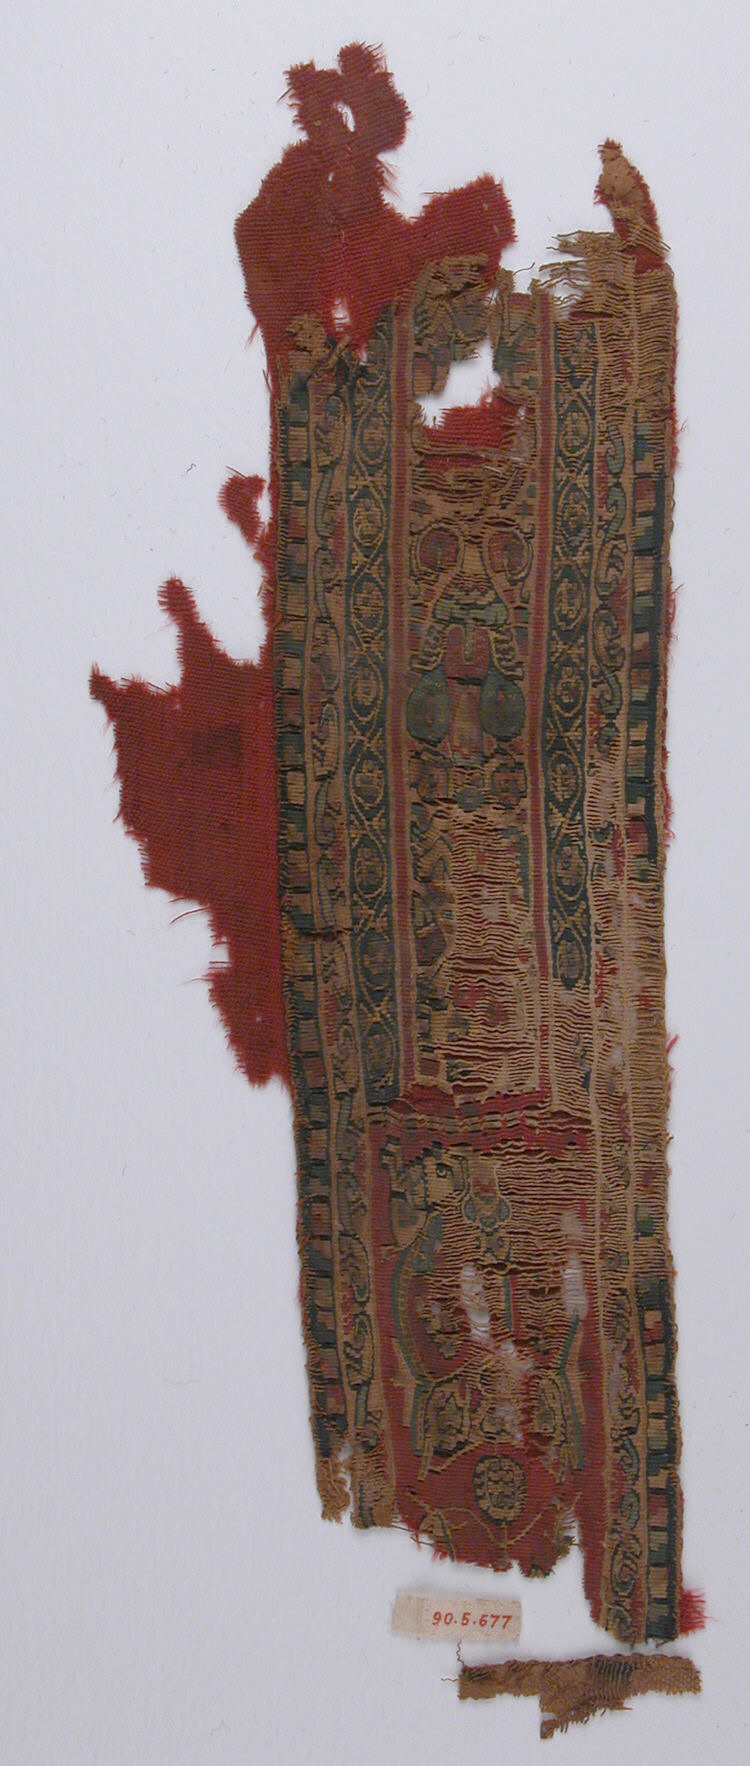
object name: textile fragment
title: Fragment of Shoulder Band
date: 601-800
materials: linen, wool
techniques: weave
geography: egypt